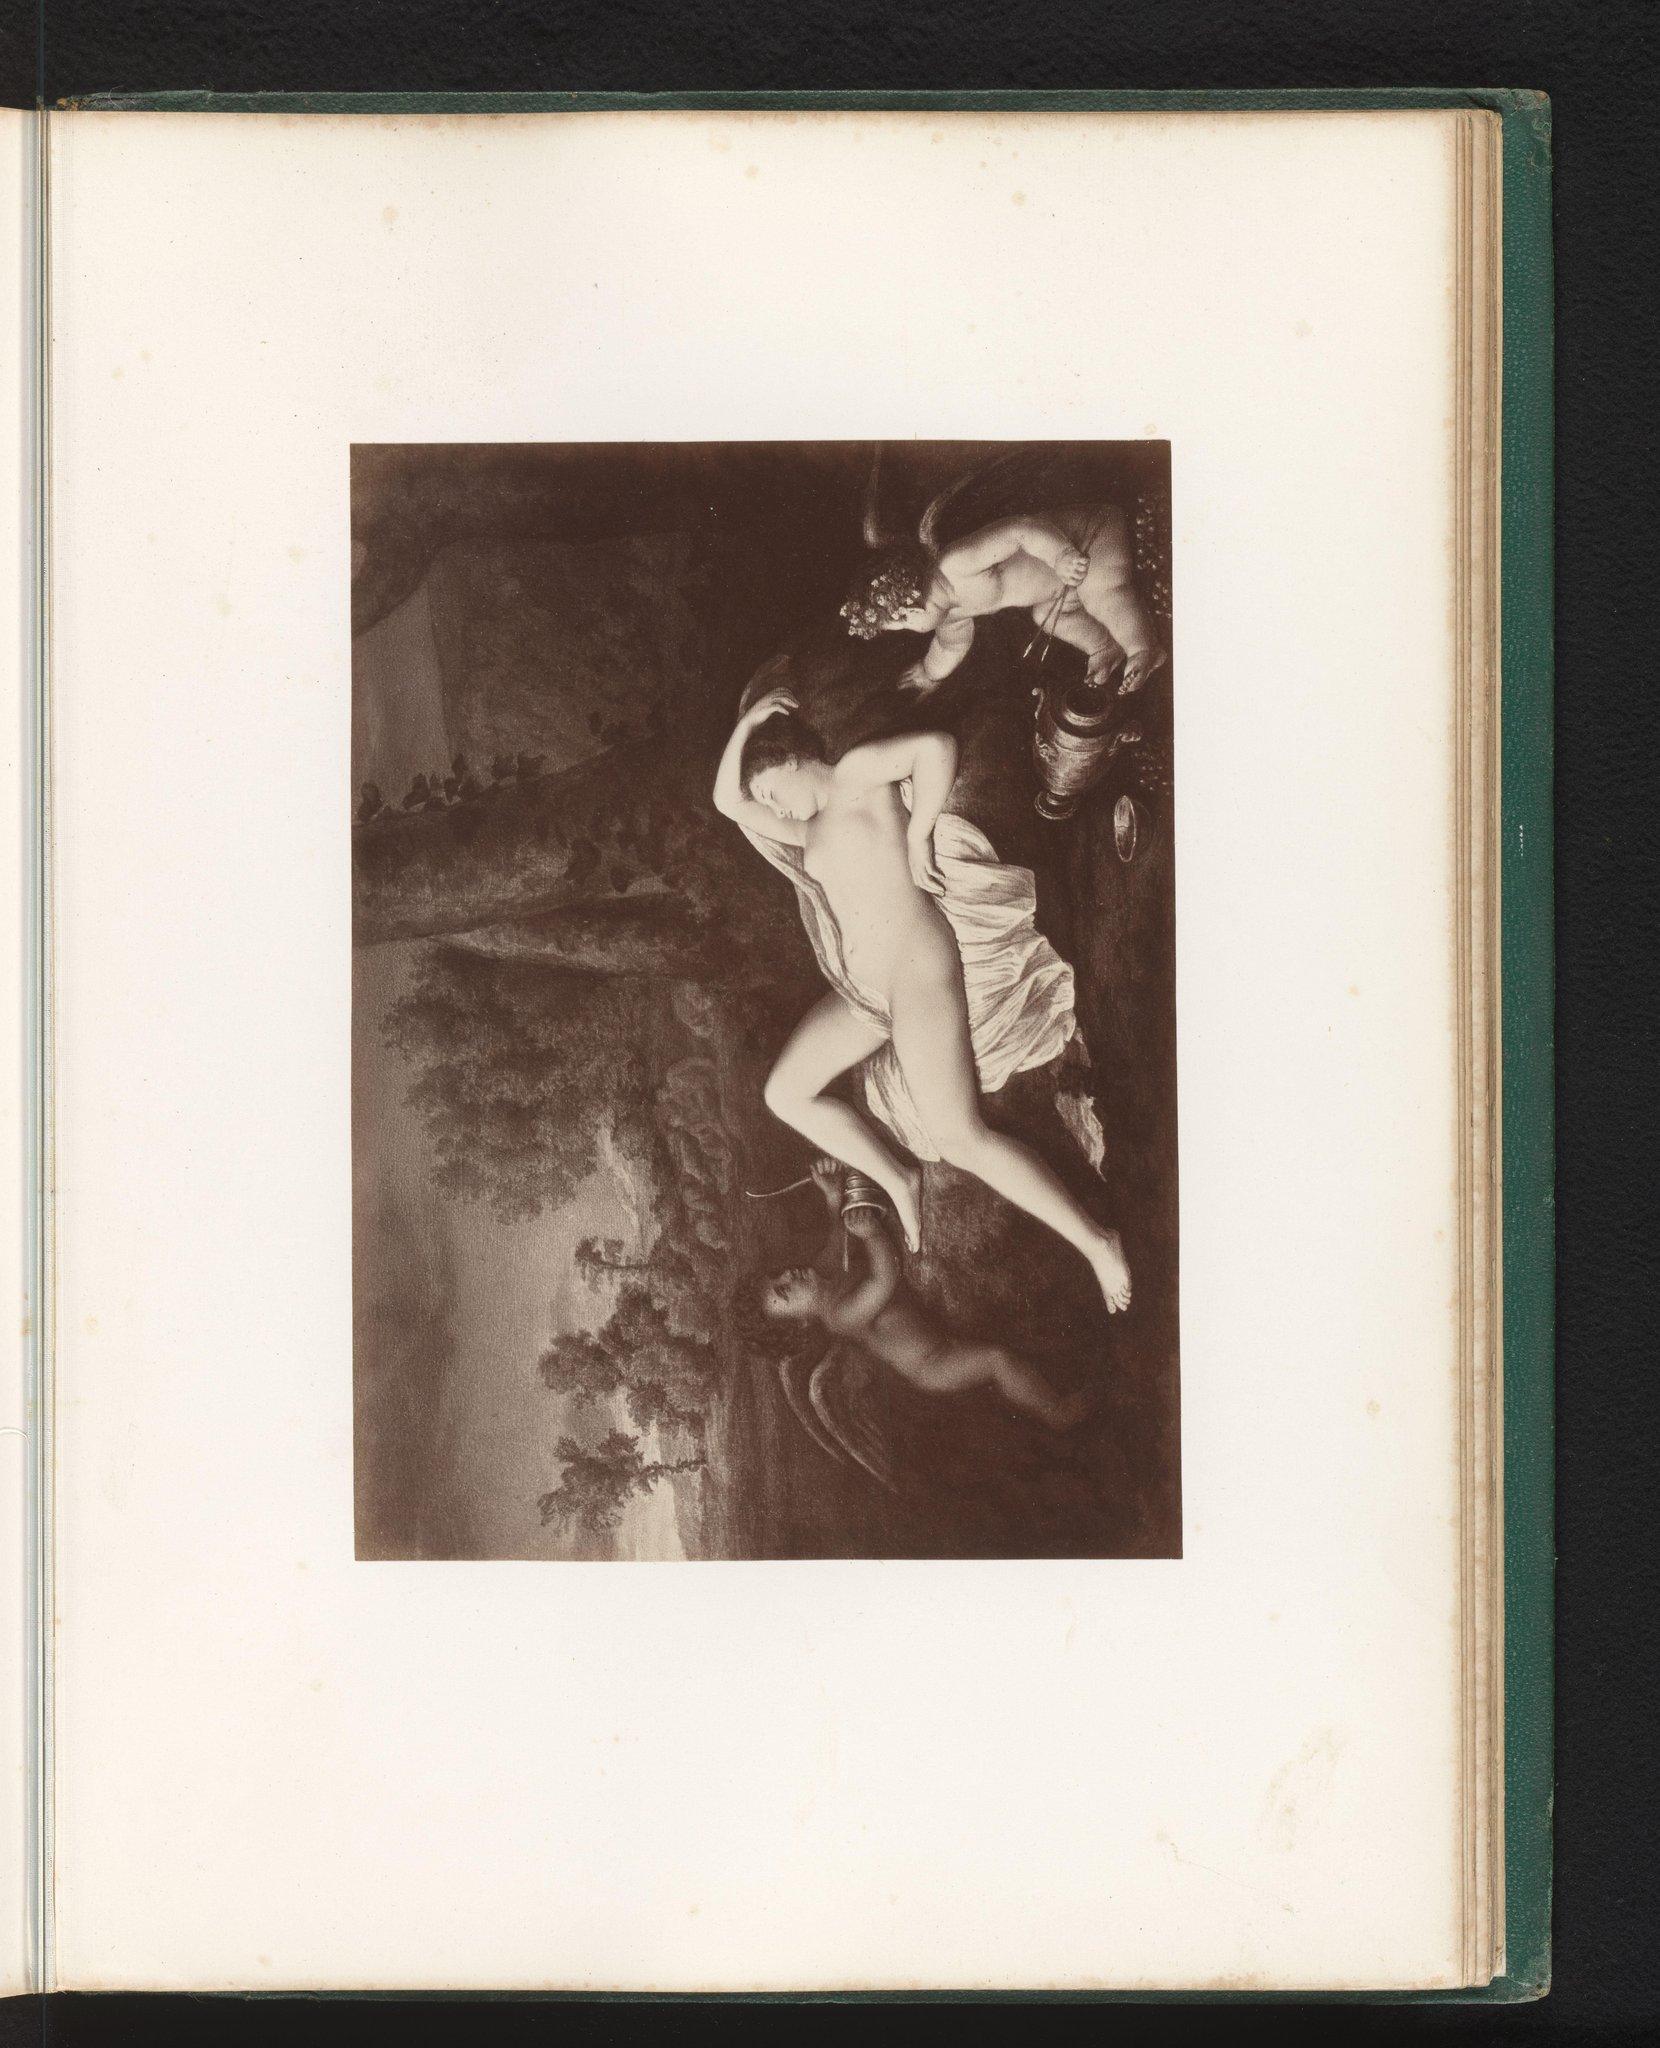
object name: photograph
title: N. Poussin: Schlafende Venus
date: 1870-1875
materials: paper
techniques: albumen print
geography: berlin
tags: venus asleep